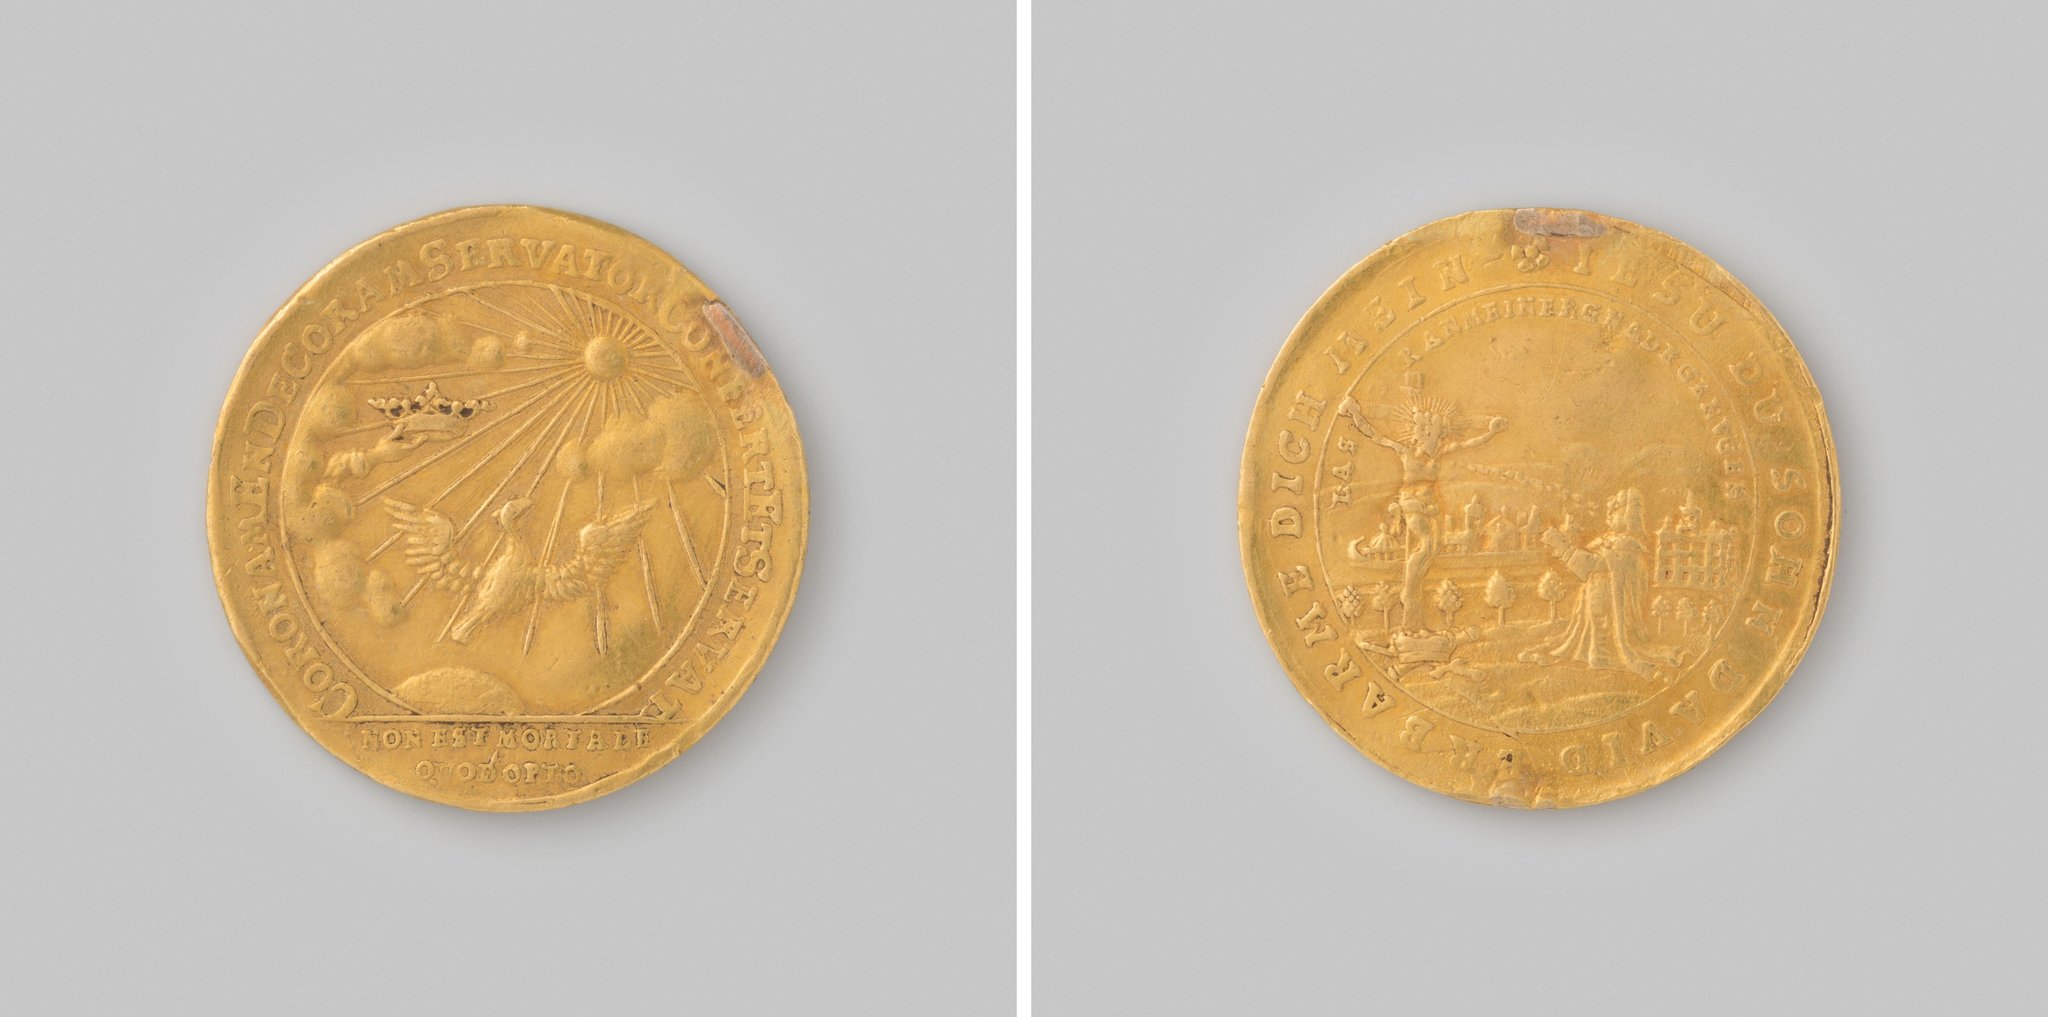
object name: ducat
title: Dukaat uit het Duitse Keizerrijk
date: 1600-1800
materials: gold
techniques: striking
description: Gouden gelegenheidsmunt. Voorzijde: tenmidden van enkele wolken stralende zon, waarnaar een adelaar opvliegt. aan de linkerhand reikt een arm met hand uit een wolk een kroon aan. Keerzijde: bijbels tafereel met de Here Jezus aan het kruis. Op de achtergrond gebouwen. Gladde rand.